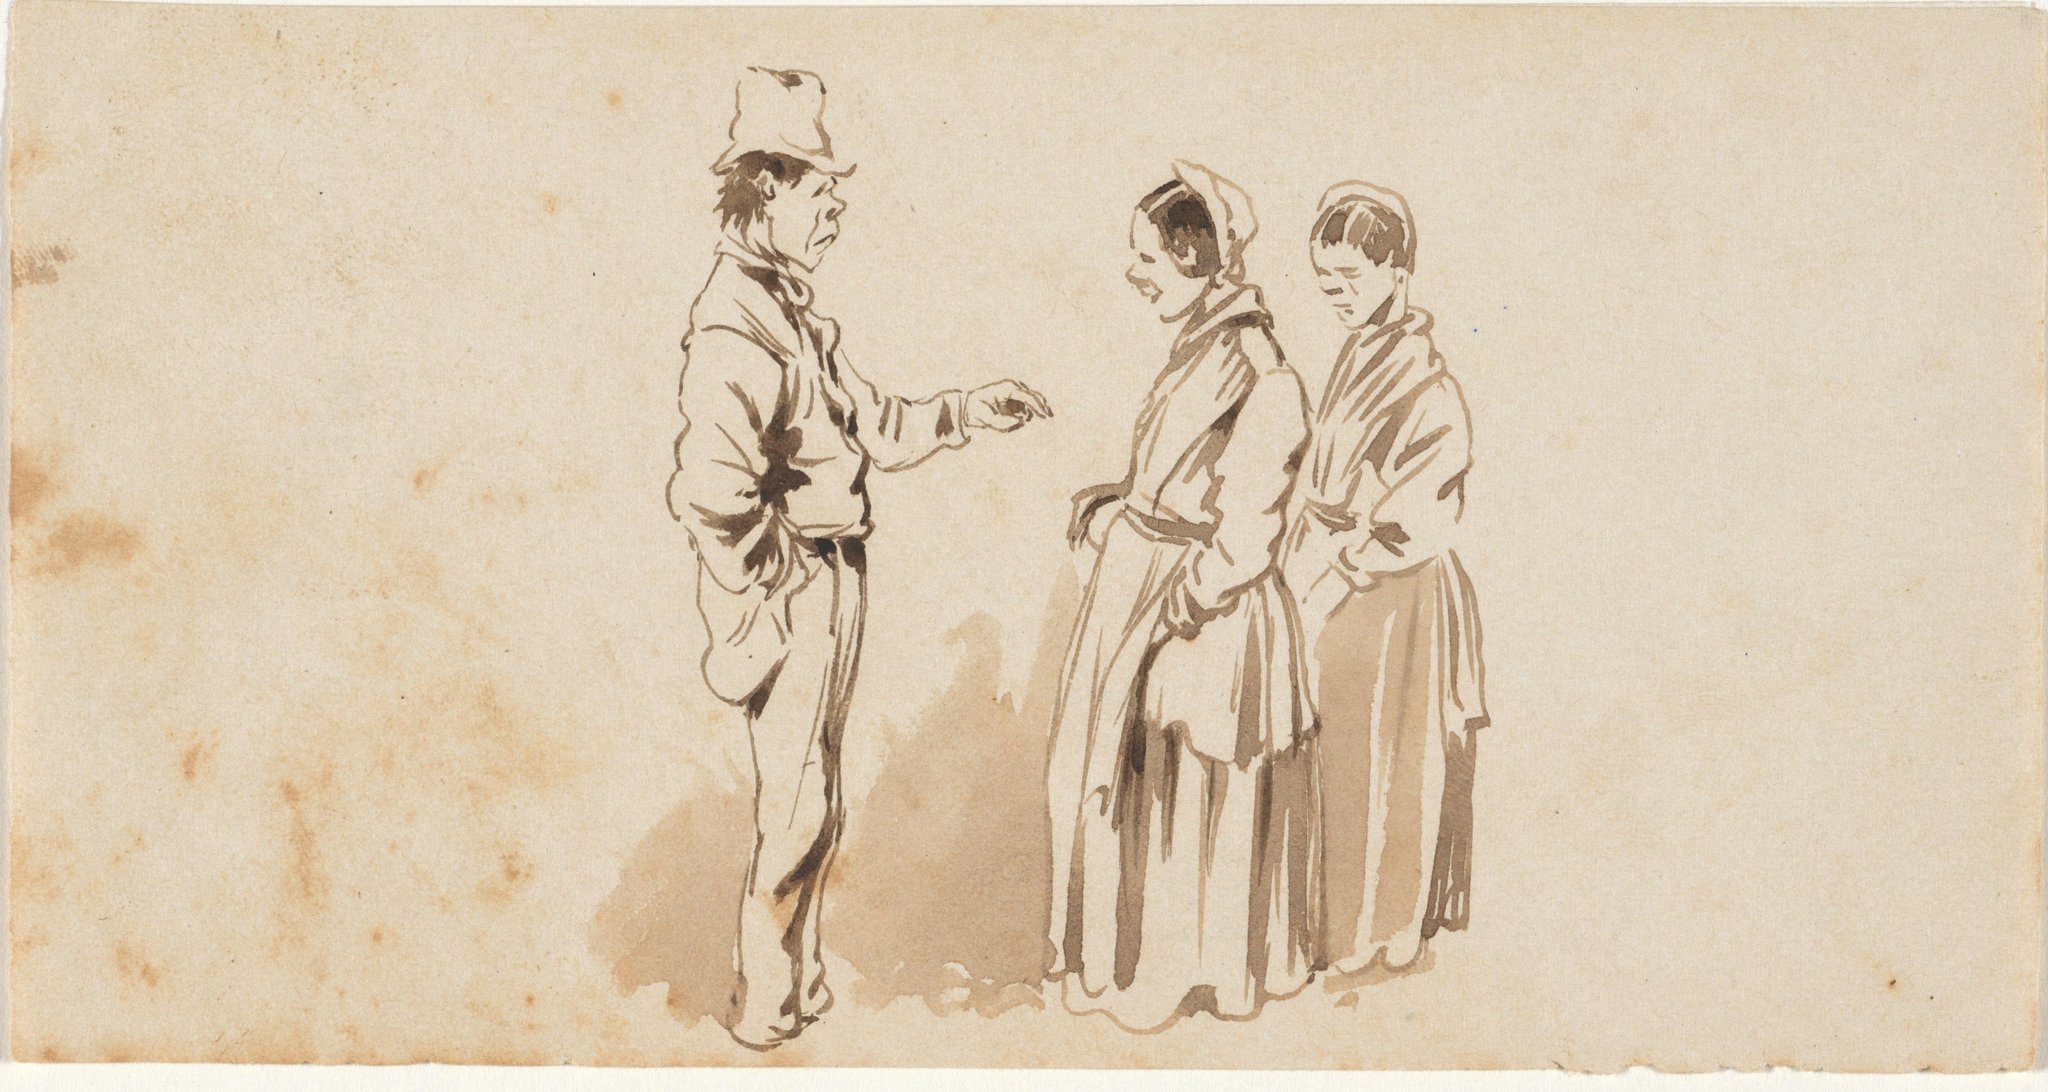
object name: drawing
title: Man pratend met twee vrouwen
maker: pieter van loon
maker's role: draughtsman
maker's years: 1801-1873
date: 1811-1873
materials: paper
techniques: brush, pen